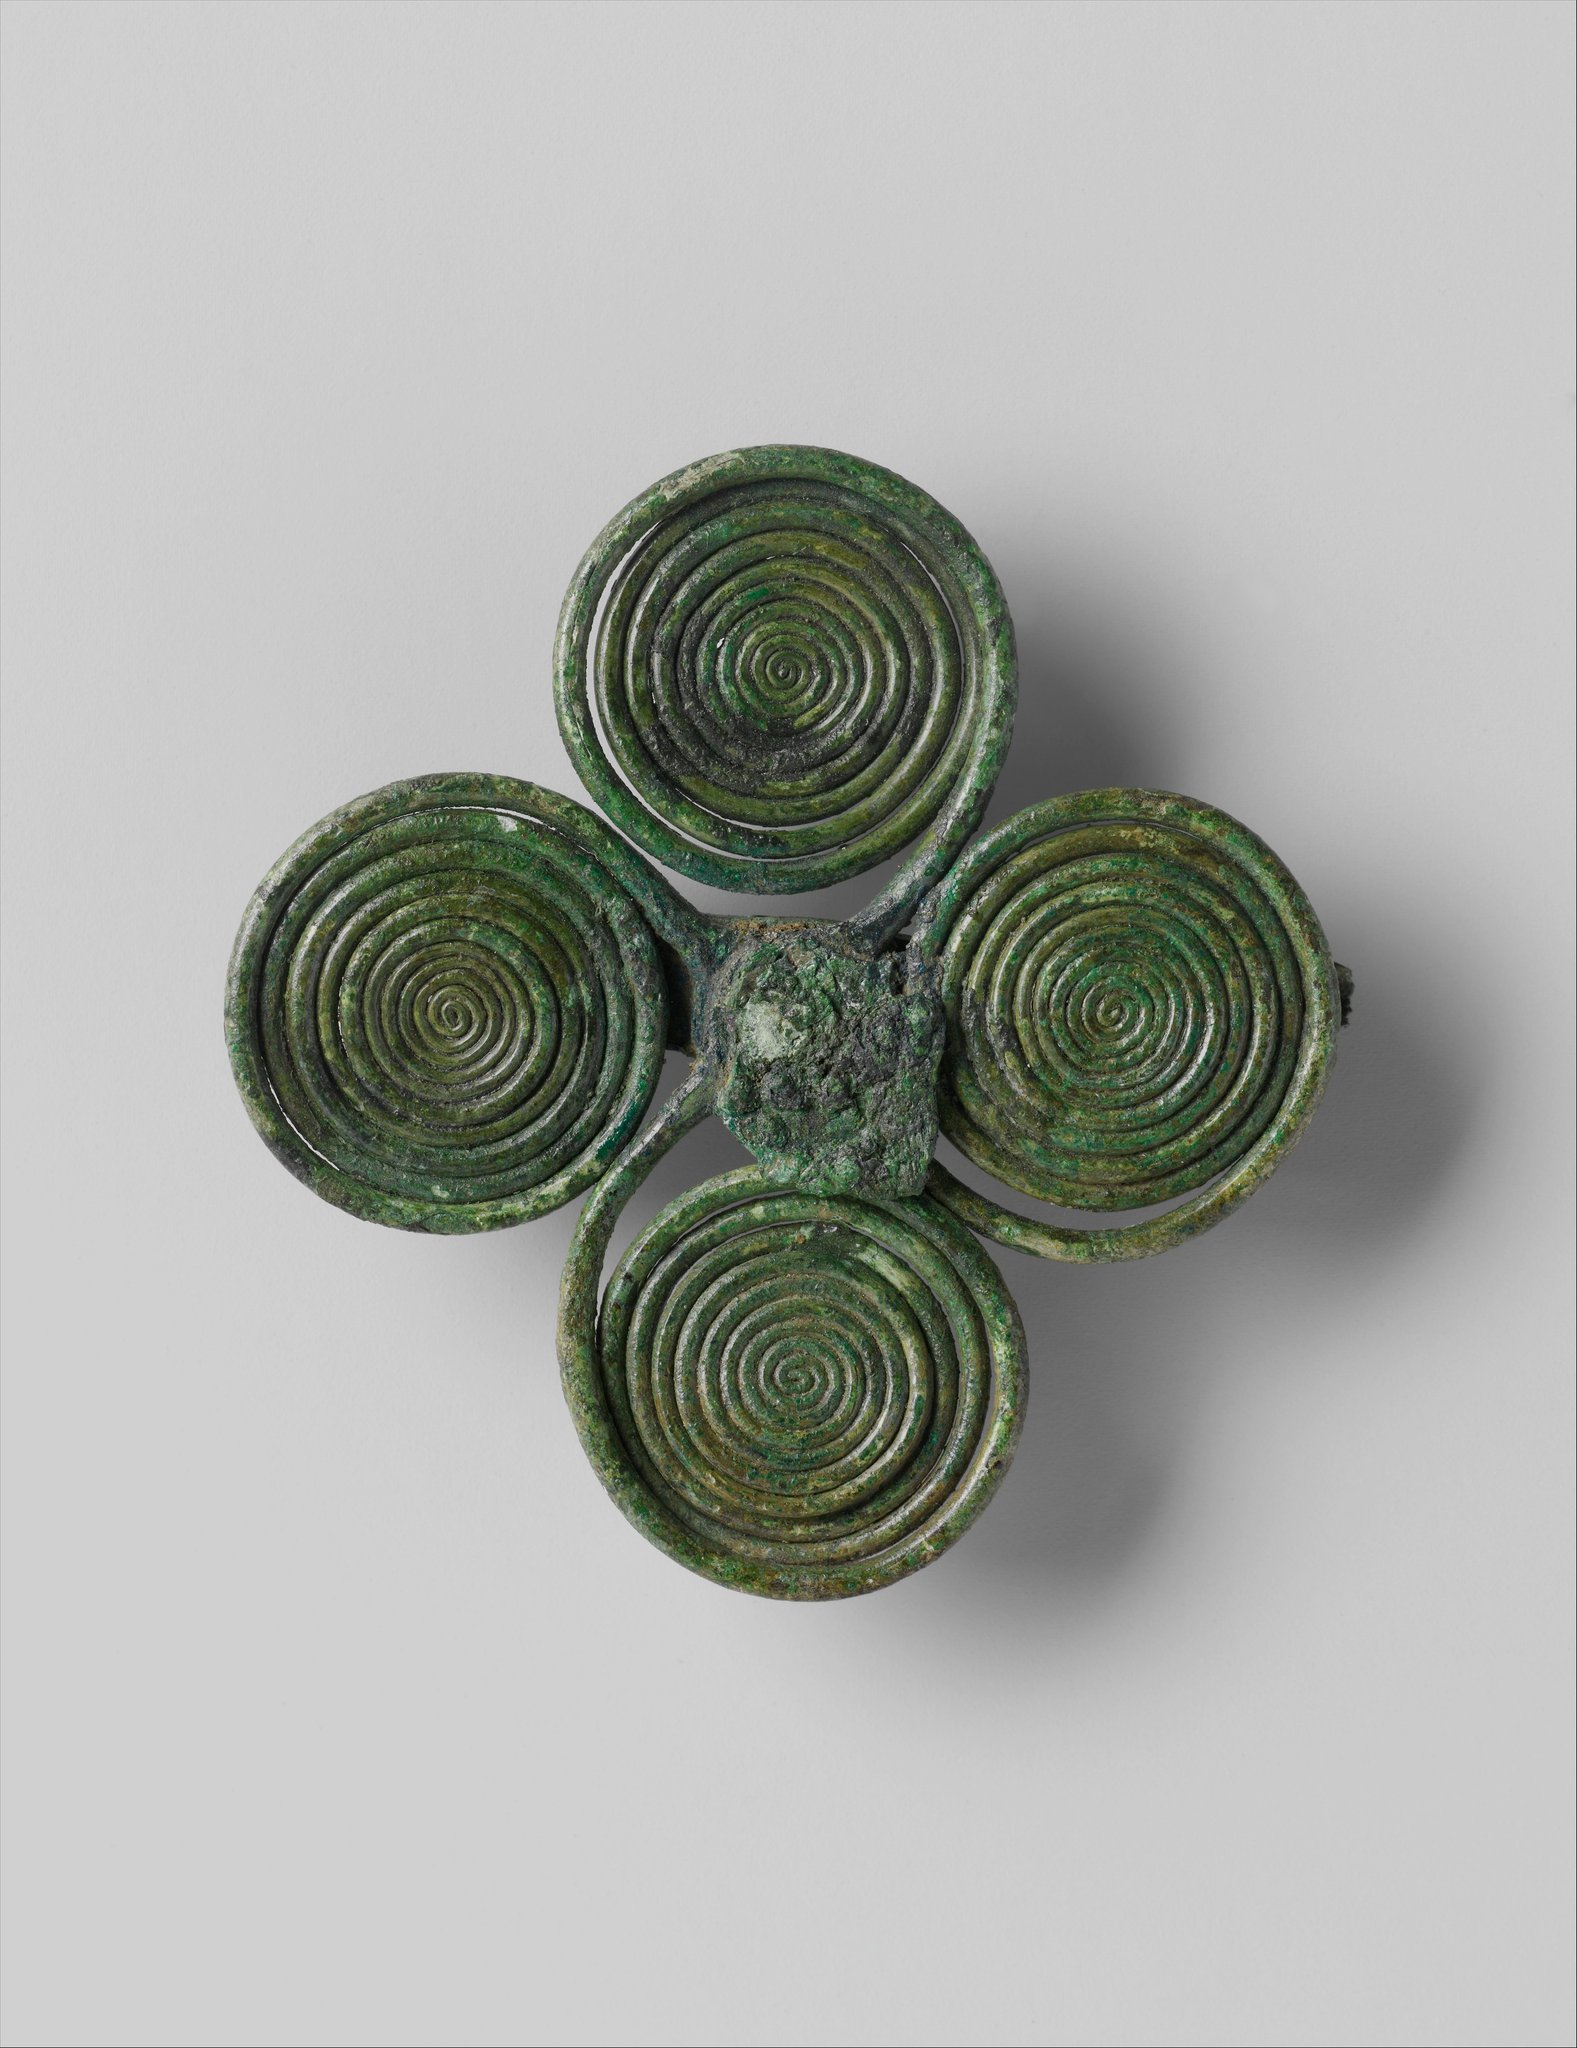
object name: brooch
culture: european bronze age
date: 800-701 BCE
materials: copper alloy